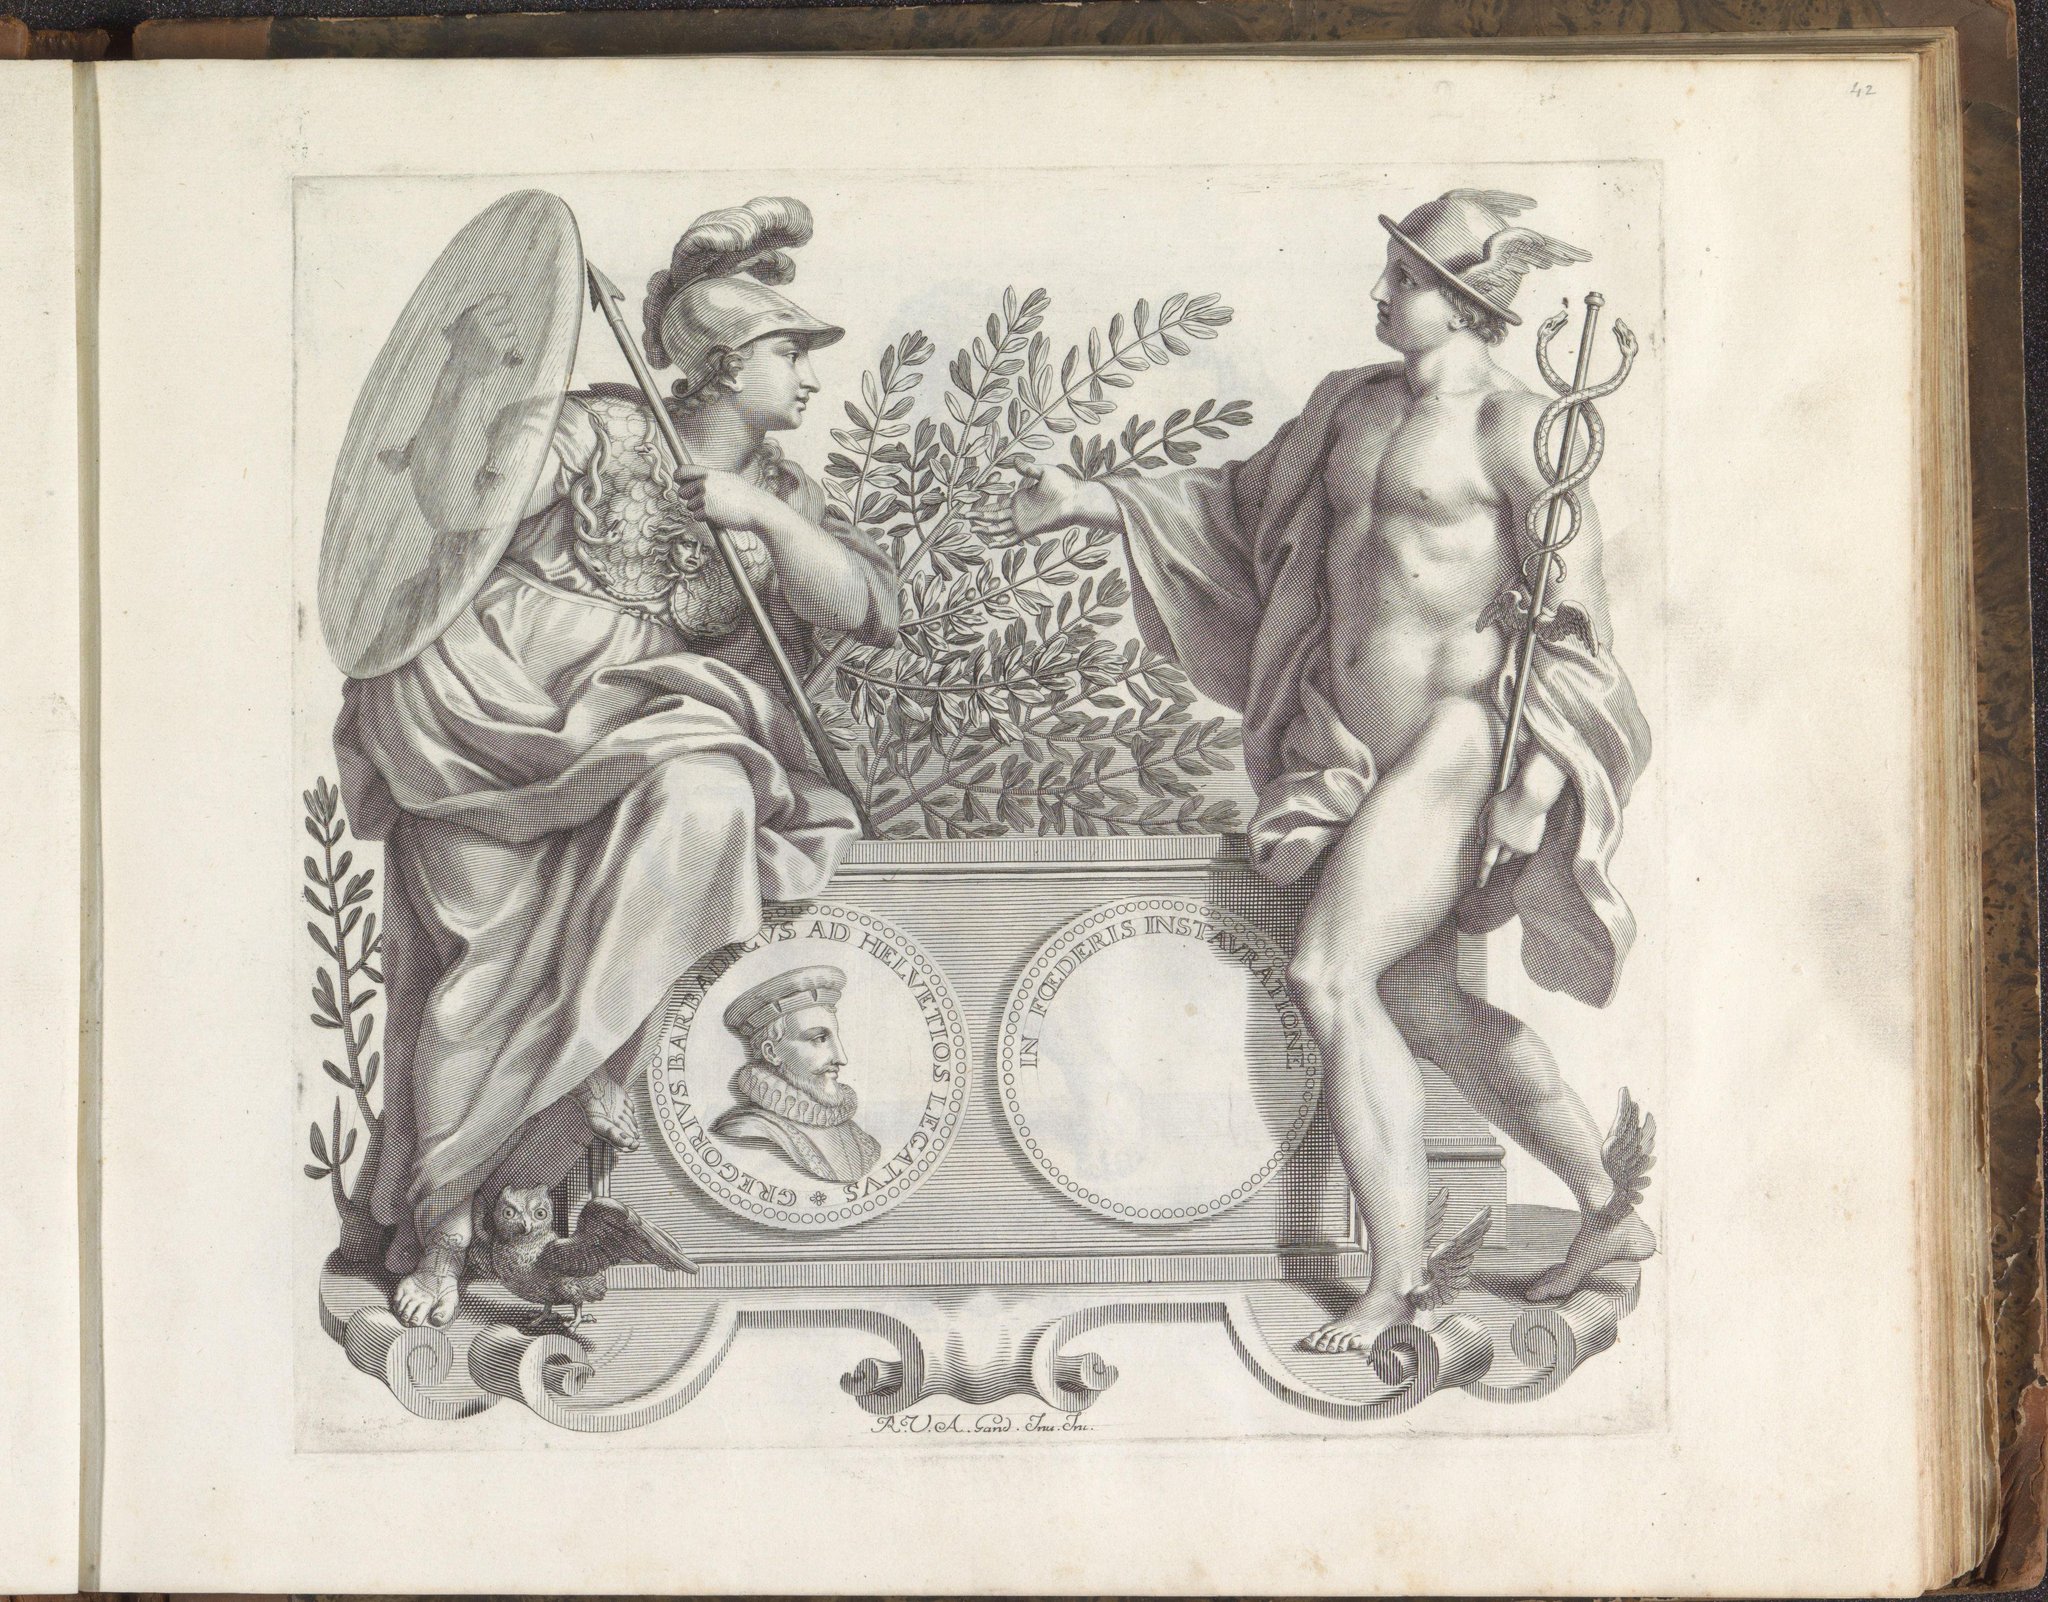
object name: print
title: Numismata virorum illustrium ex Barbadica gente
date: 1673-1743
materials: paper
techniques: engraving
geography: rome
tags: (story of) minerva (pallas, athena), (story of) mercury (hermes), trees: laurel, medal (considered as a piece of sculpture, regardless of its specific function), owls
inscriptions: collector's mark: Lugt 2228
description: Voetstuk in de vorm van een cartouche. Daarop een medaillon met op de voorzijde het portret van Giorgio Barbarigo, Venetiaans ambassadeur in Zweden. Op de achterzijde alleen de spreuk: In Foederis Instauratione. Het voetstuk wordt geflankeerd door Minerva en Mercurius. De prent maakt deel uit van een album.